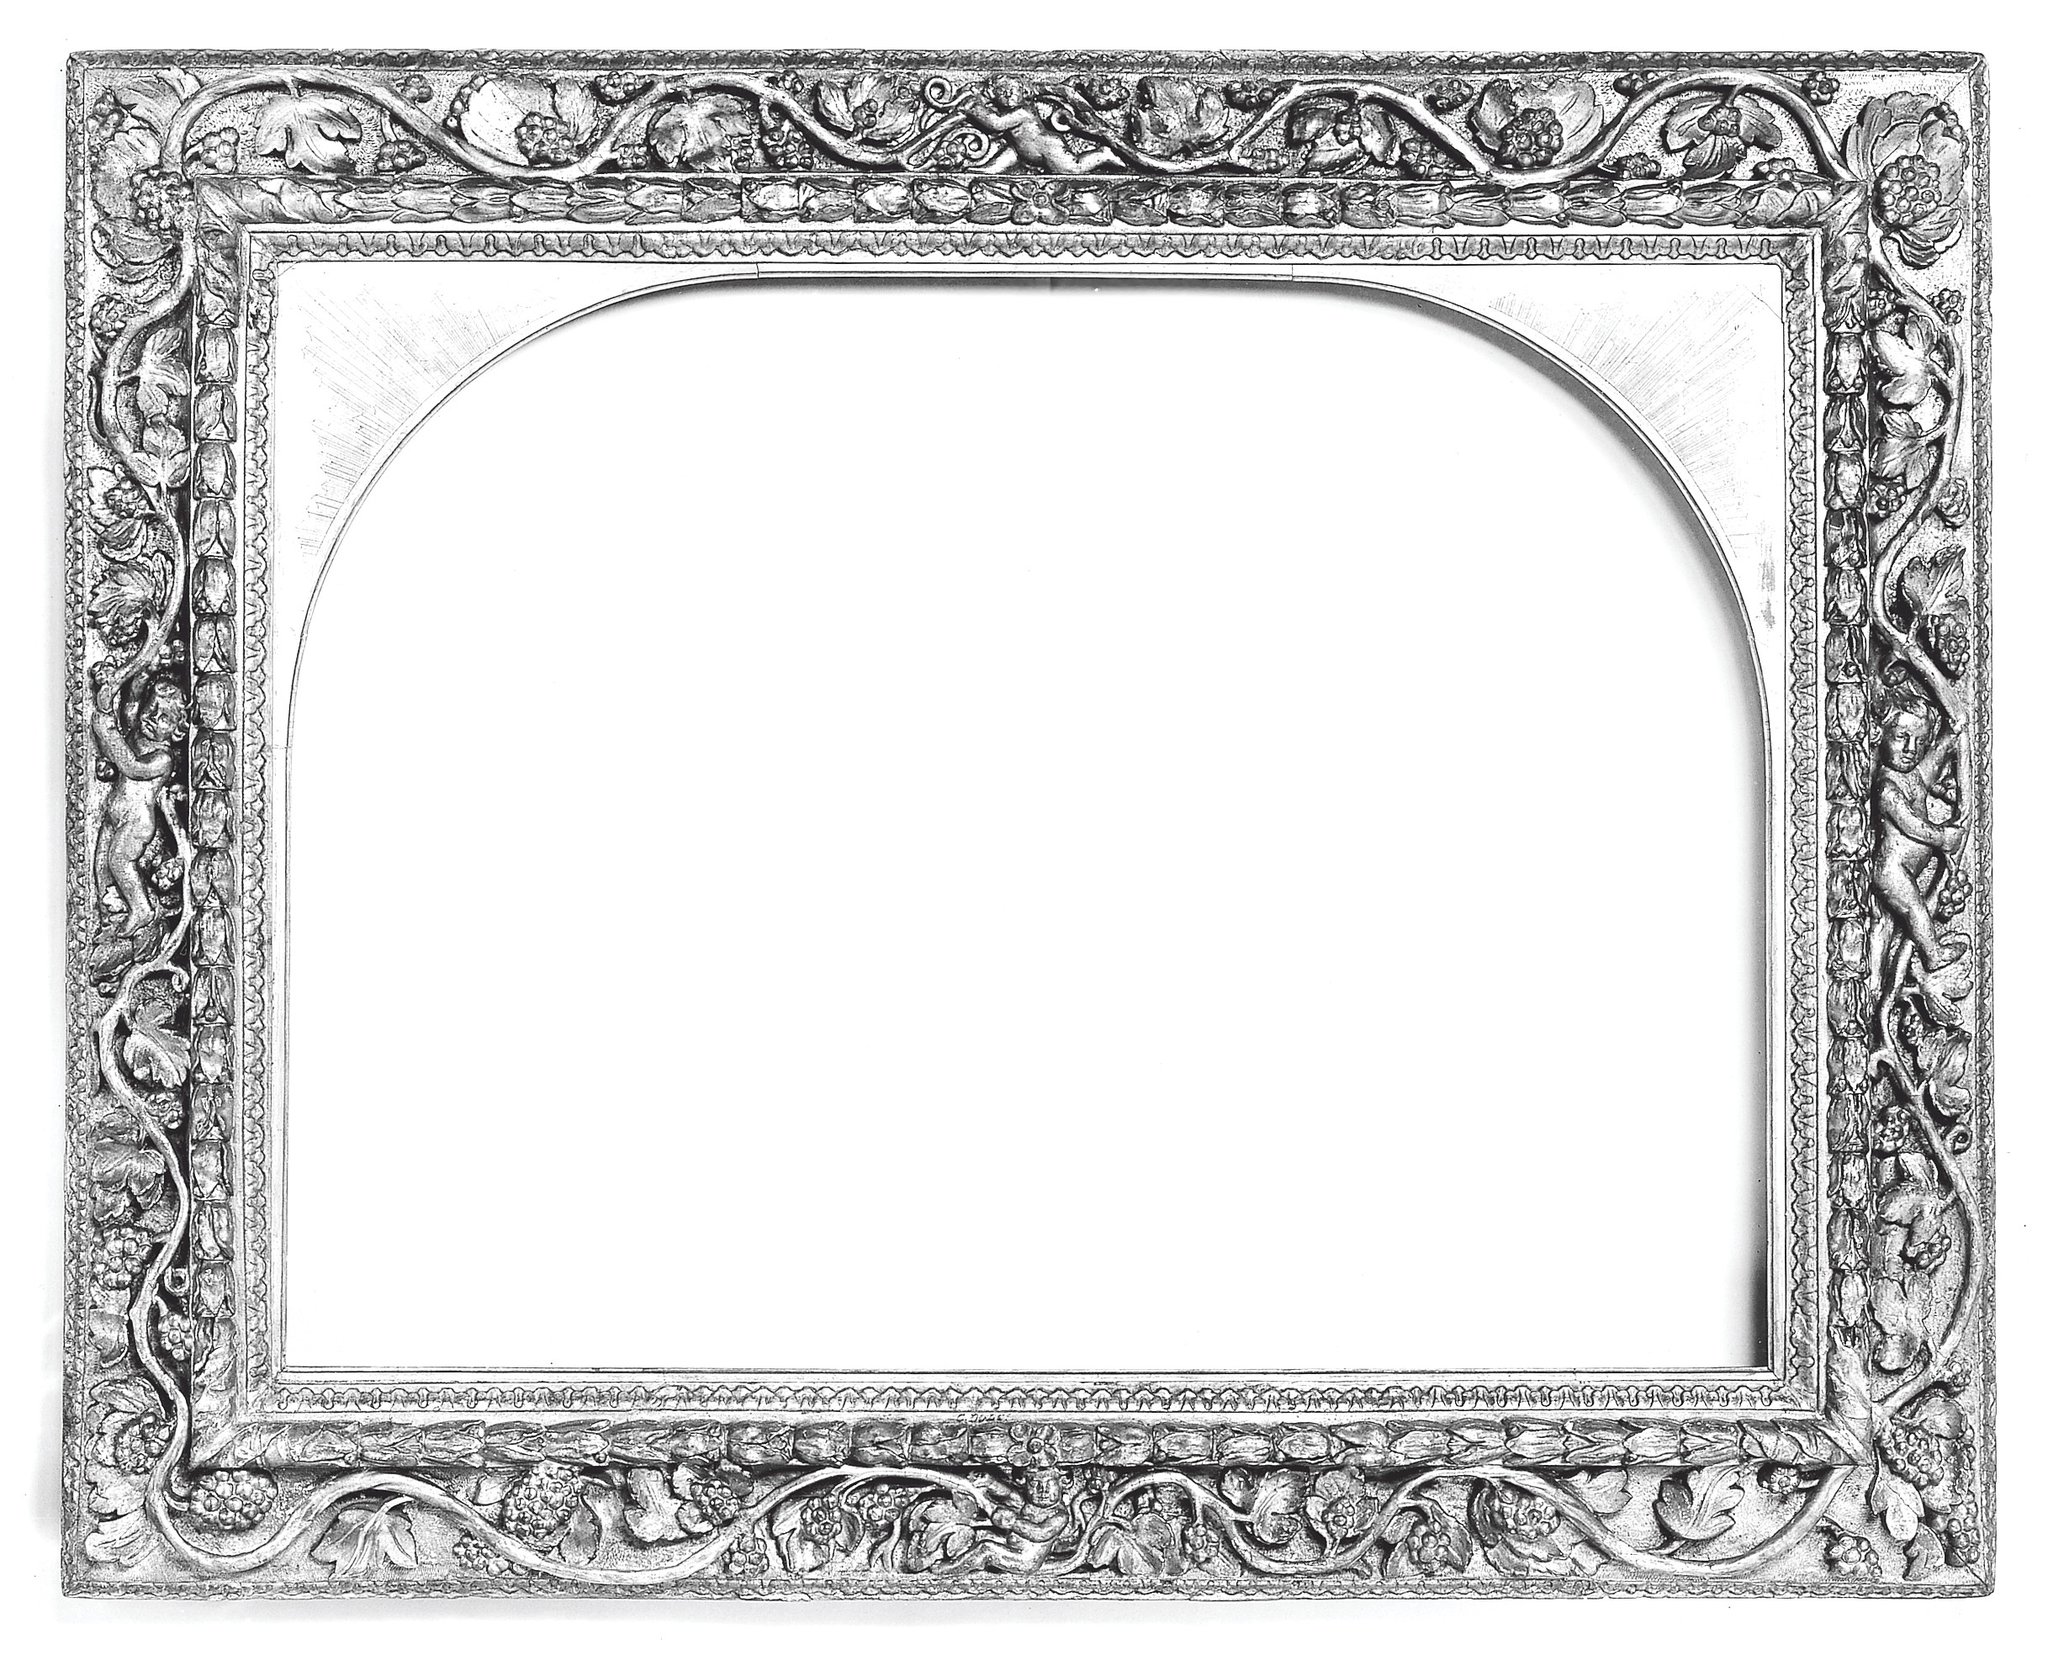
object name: frame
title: Reverse cassetta frame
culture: french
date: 1630-1640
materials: wood